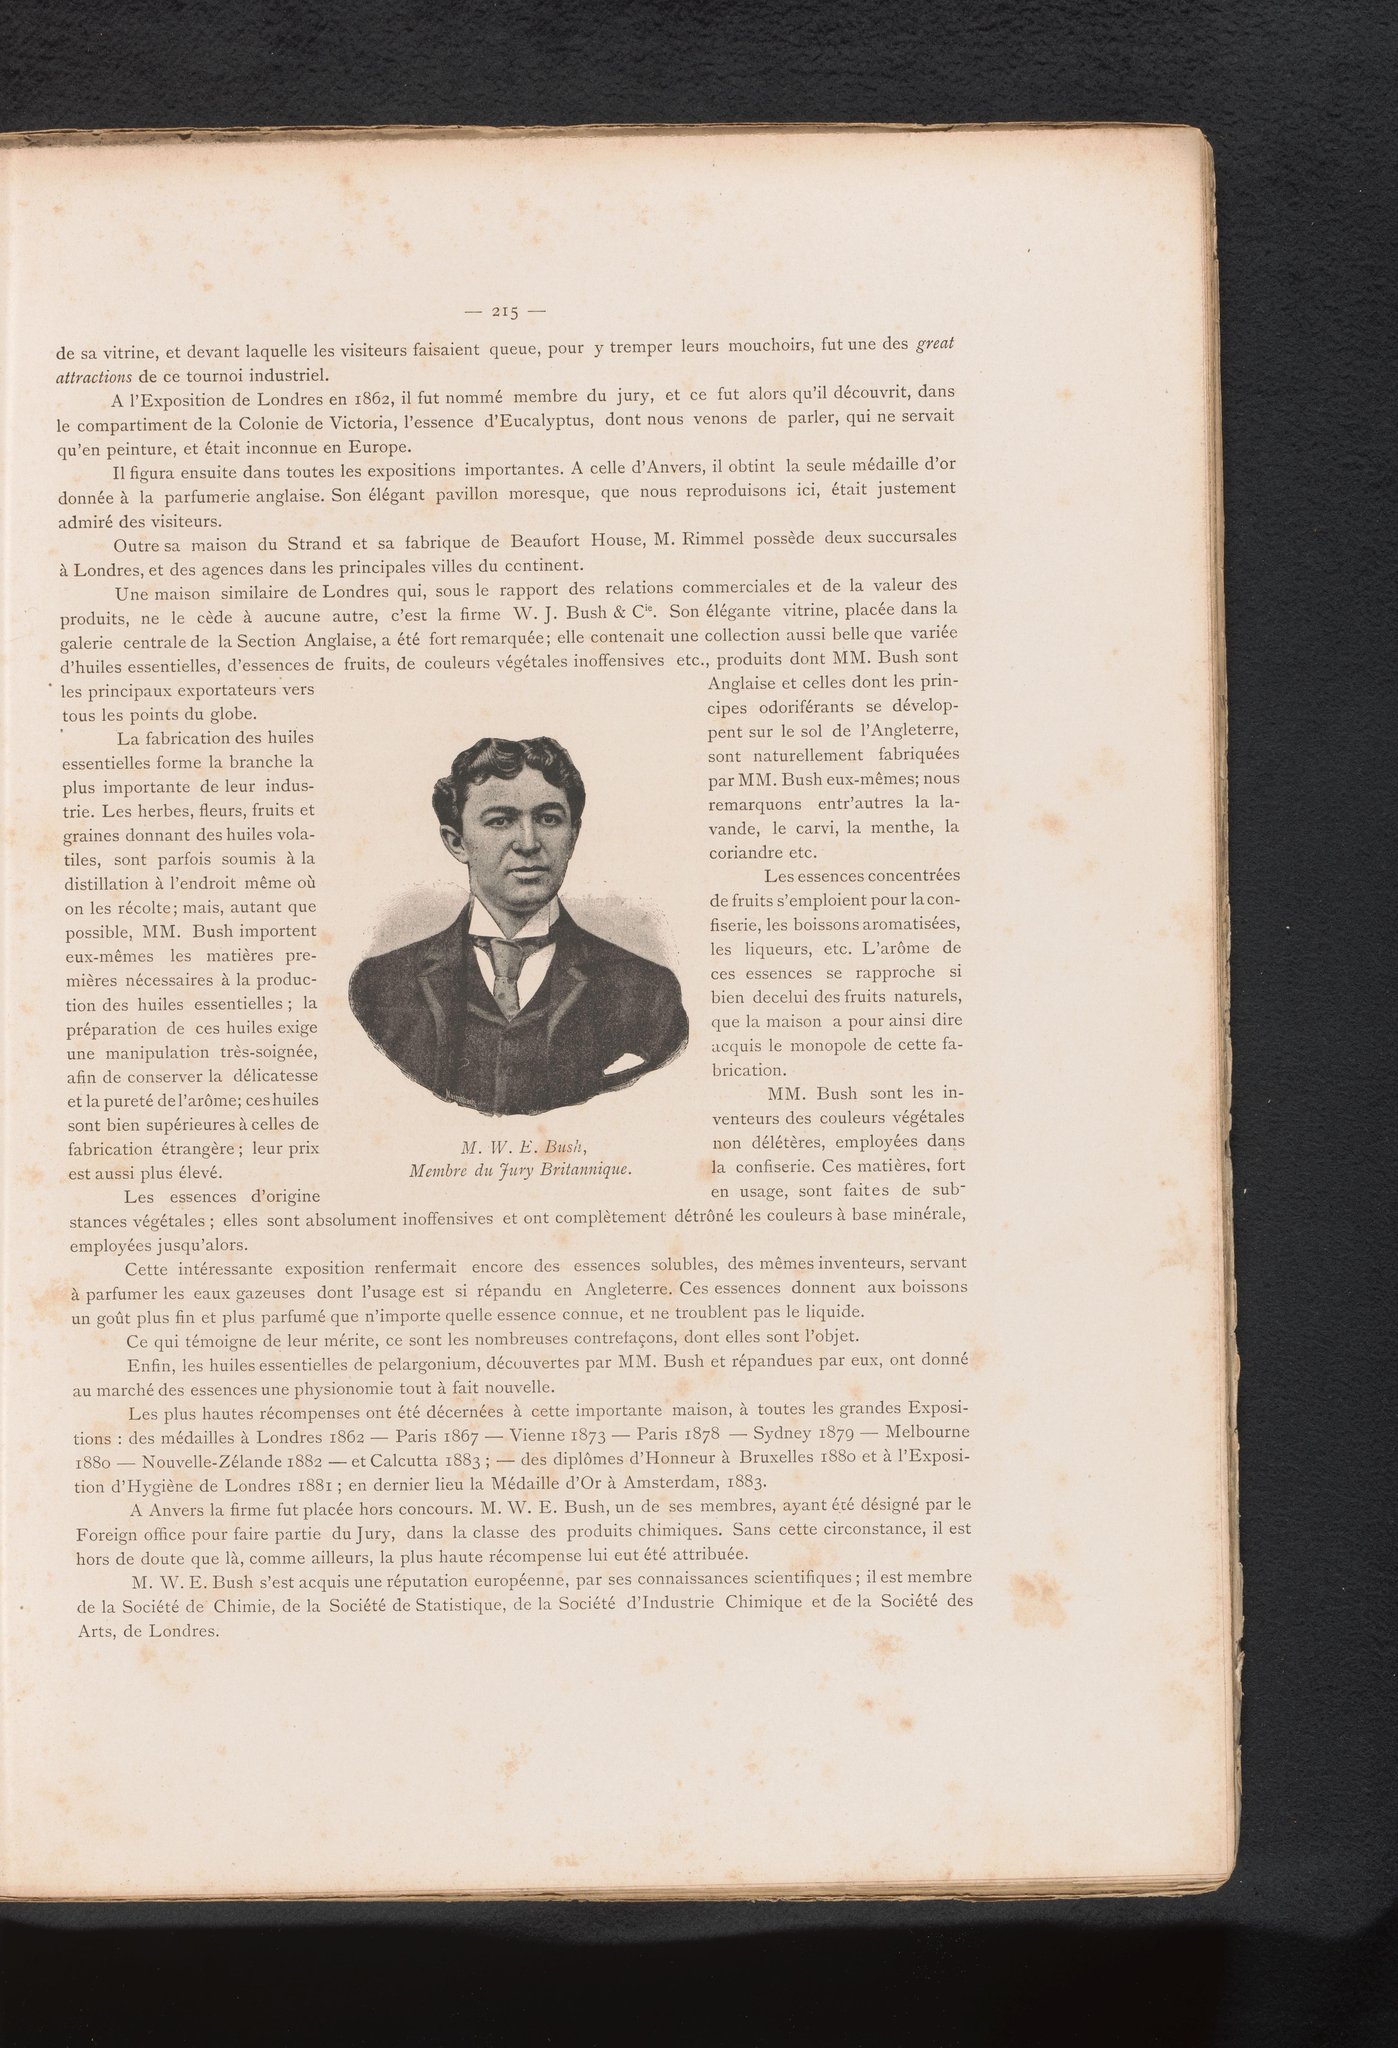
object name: page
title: Portret van W.E. Bush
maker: Anonymous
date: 1880-1885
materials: paper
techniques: autotype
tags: historical persons